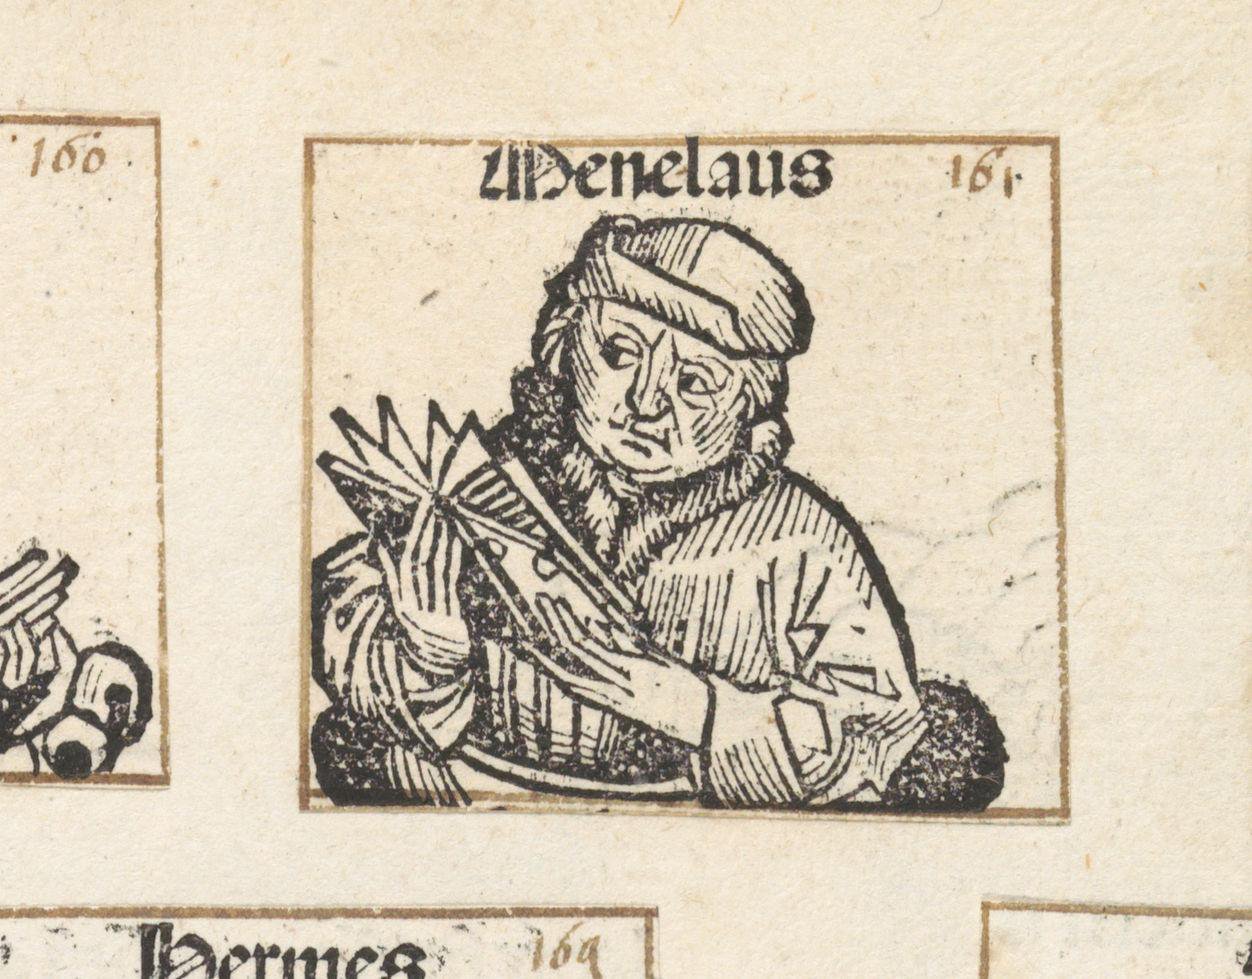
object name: album leaf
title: Liber Chronicarum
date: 1493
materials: paper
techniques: letterpress printing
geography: nuremberg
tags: persons from the old testament (not in biblical context, nor occurring in legendary/historical extensions included in division 71)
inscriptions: inscription: ‘161’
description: De houtsnede wordt gebruikt als boekillustratie in de Liber Chronicarum (of Neurenbergkroniek) van Hartmann Schedel, verschenen in het Latijn en Duits in 1493. Zie de Latijnse uitgave, folio 77r.